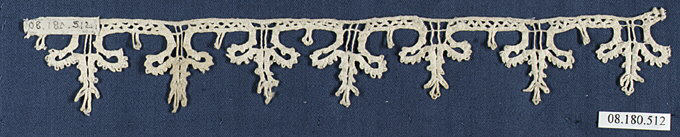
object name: fragment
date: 1601-1700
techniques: lace